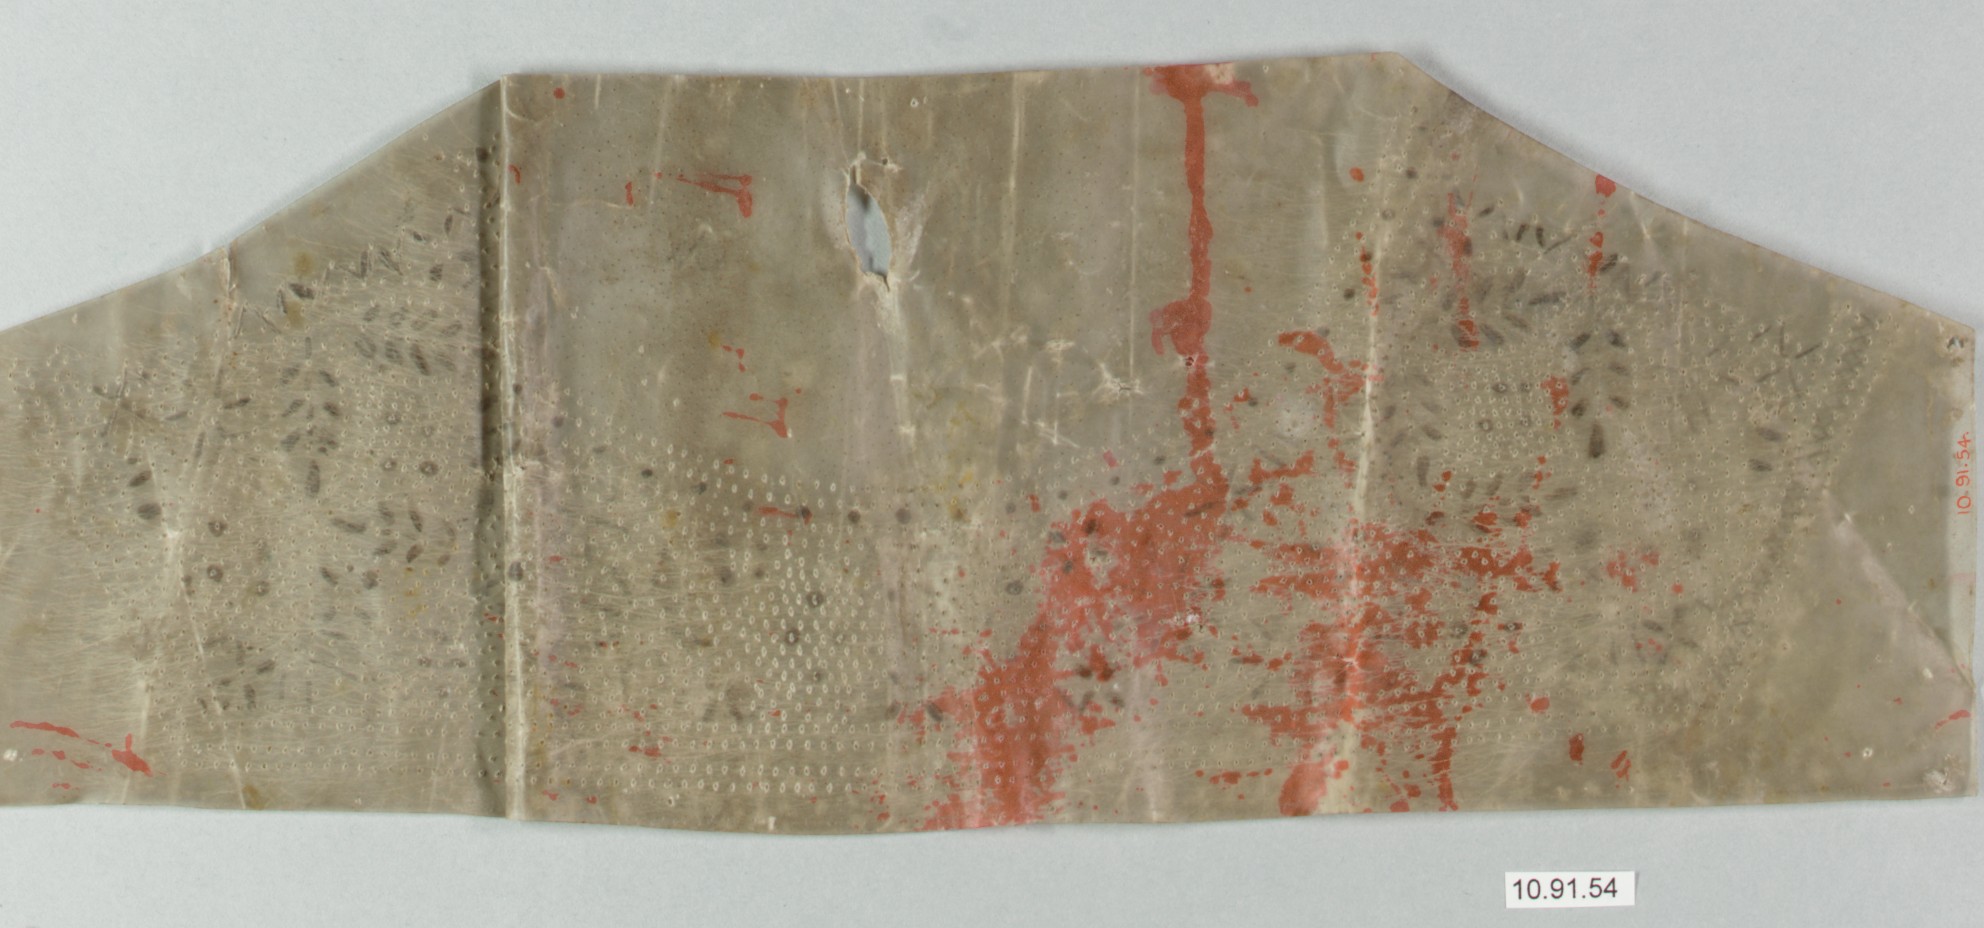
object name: pricking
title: Prickings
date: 1701-1900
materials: parchment